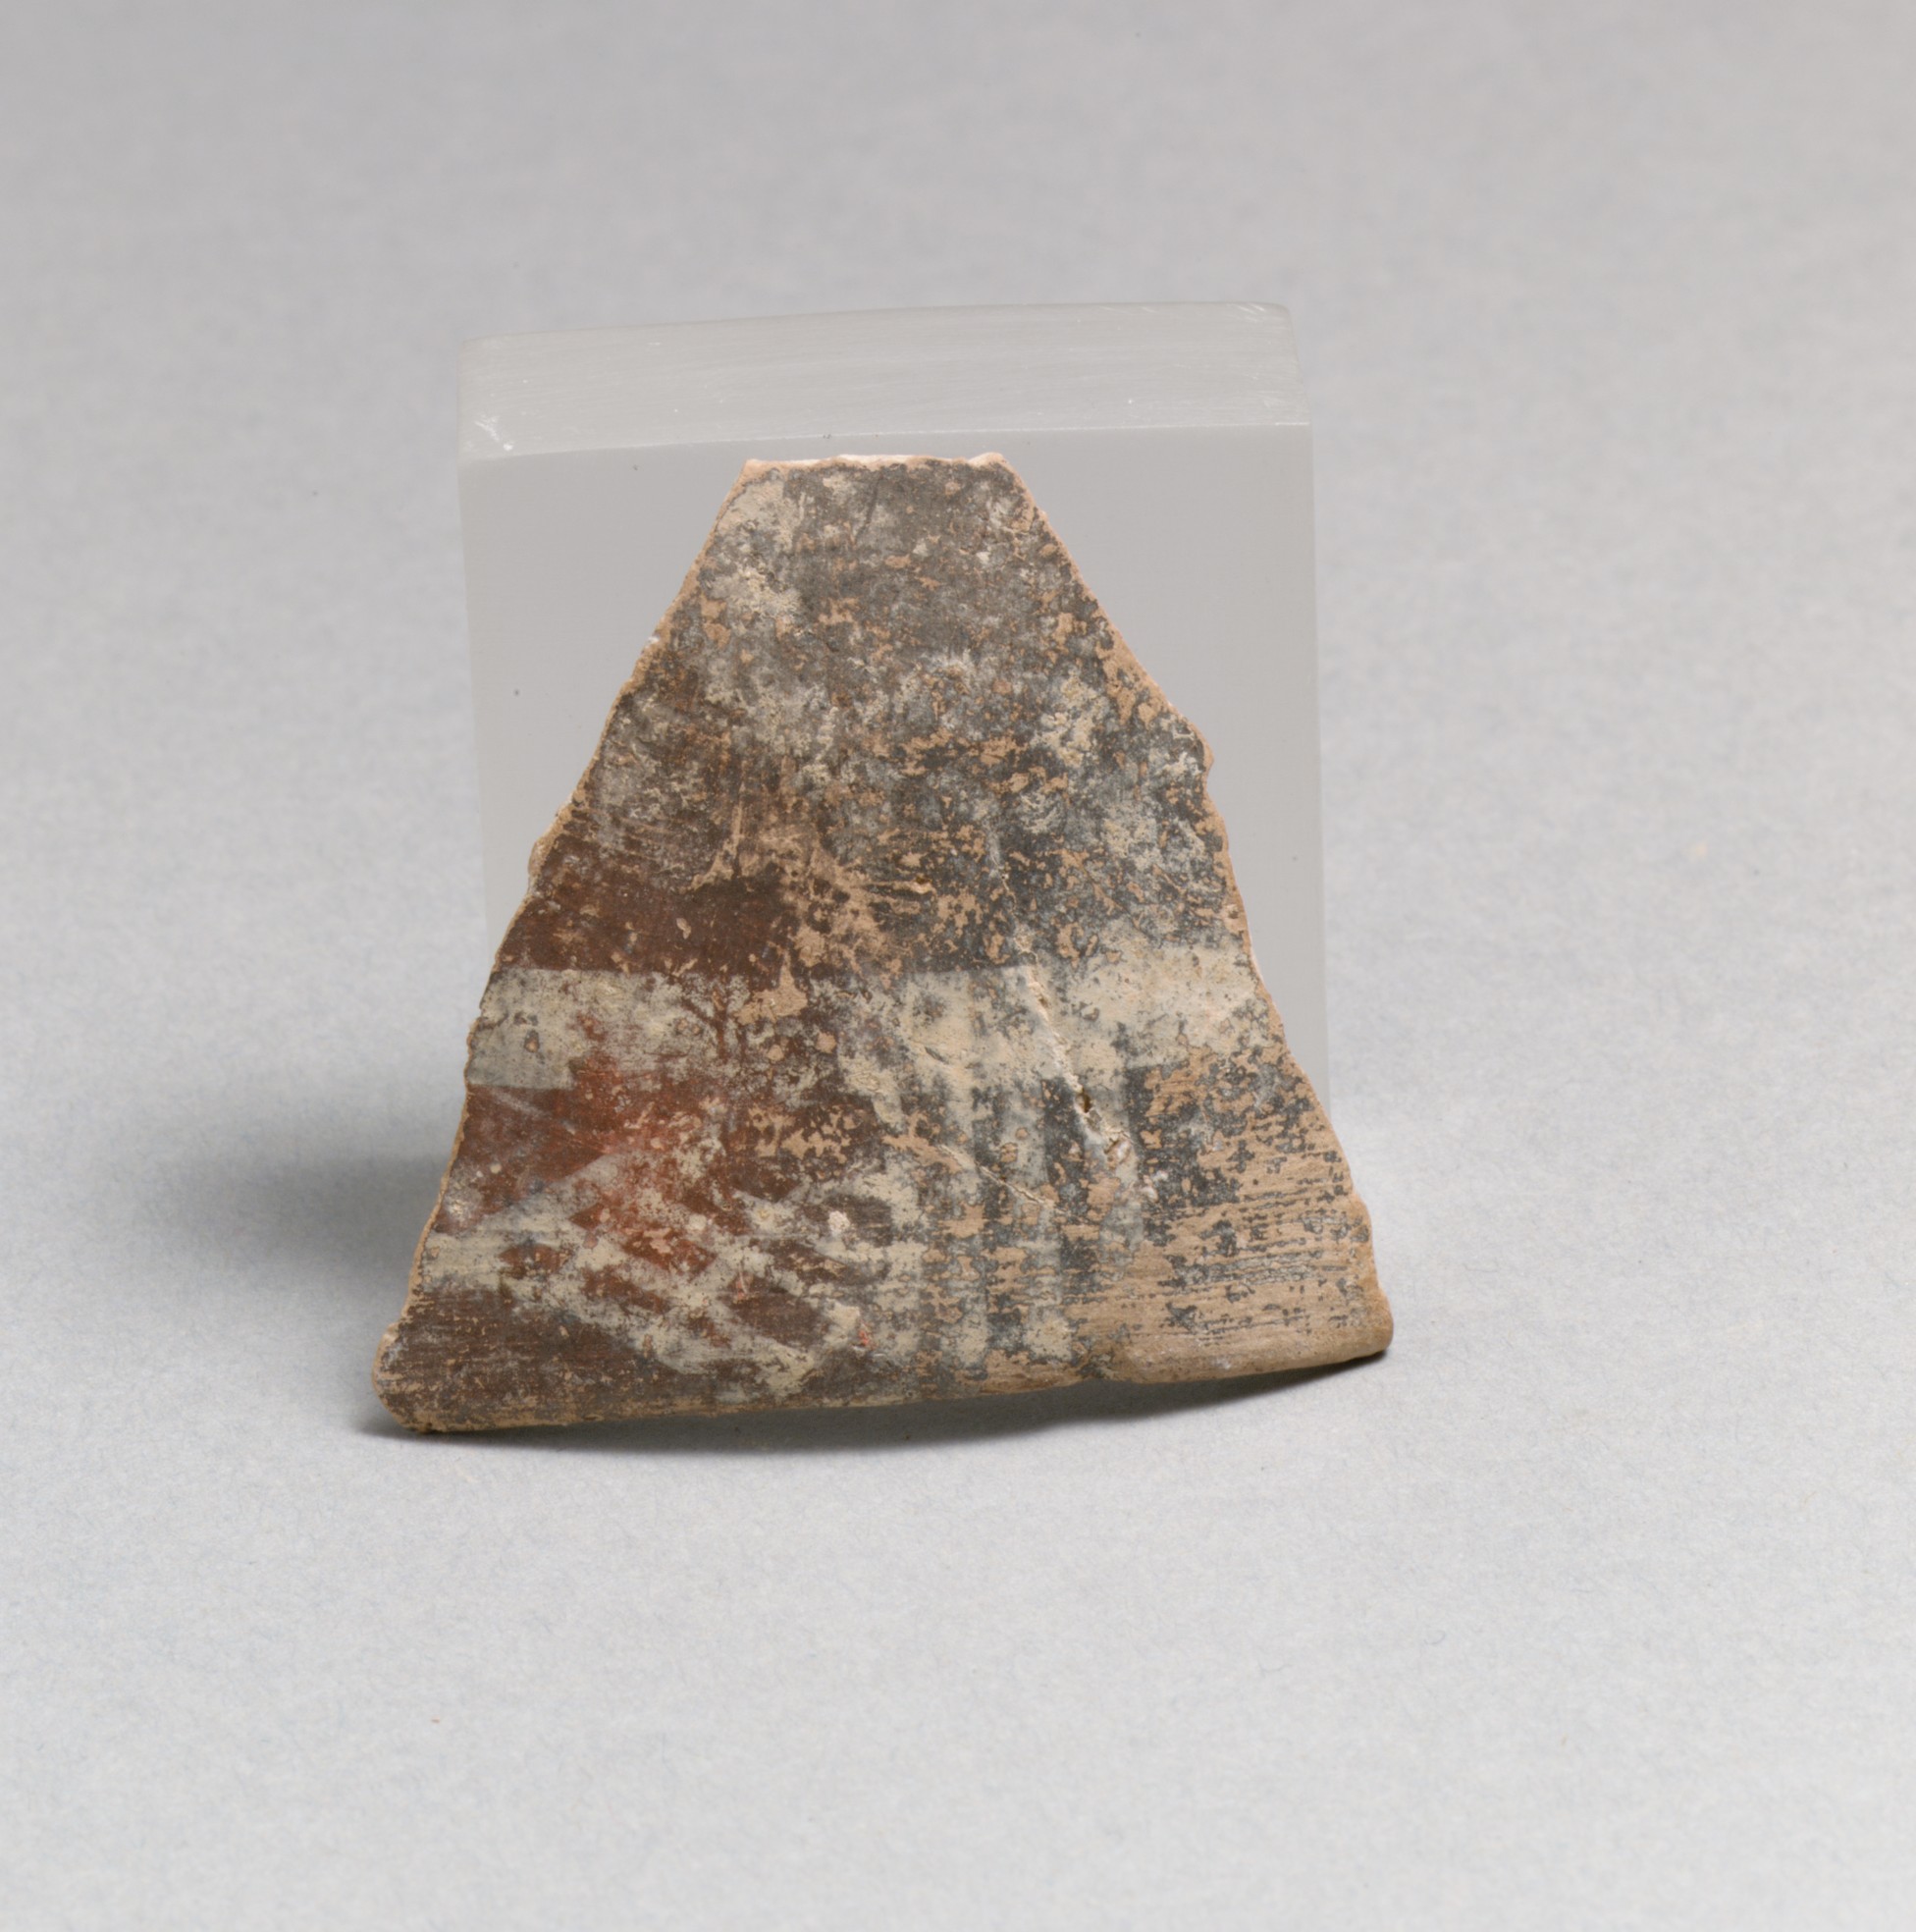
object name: vase fragment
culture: minoan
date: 2600-2000 BCE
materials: terracotta